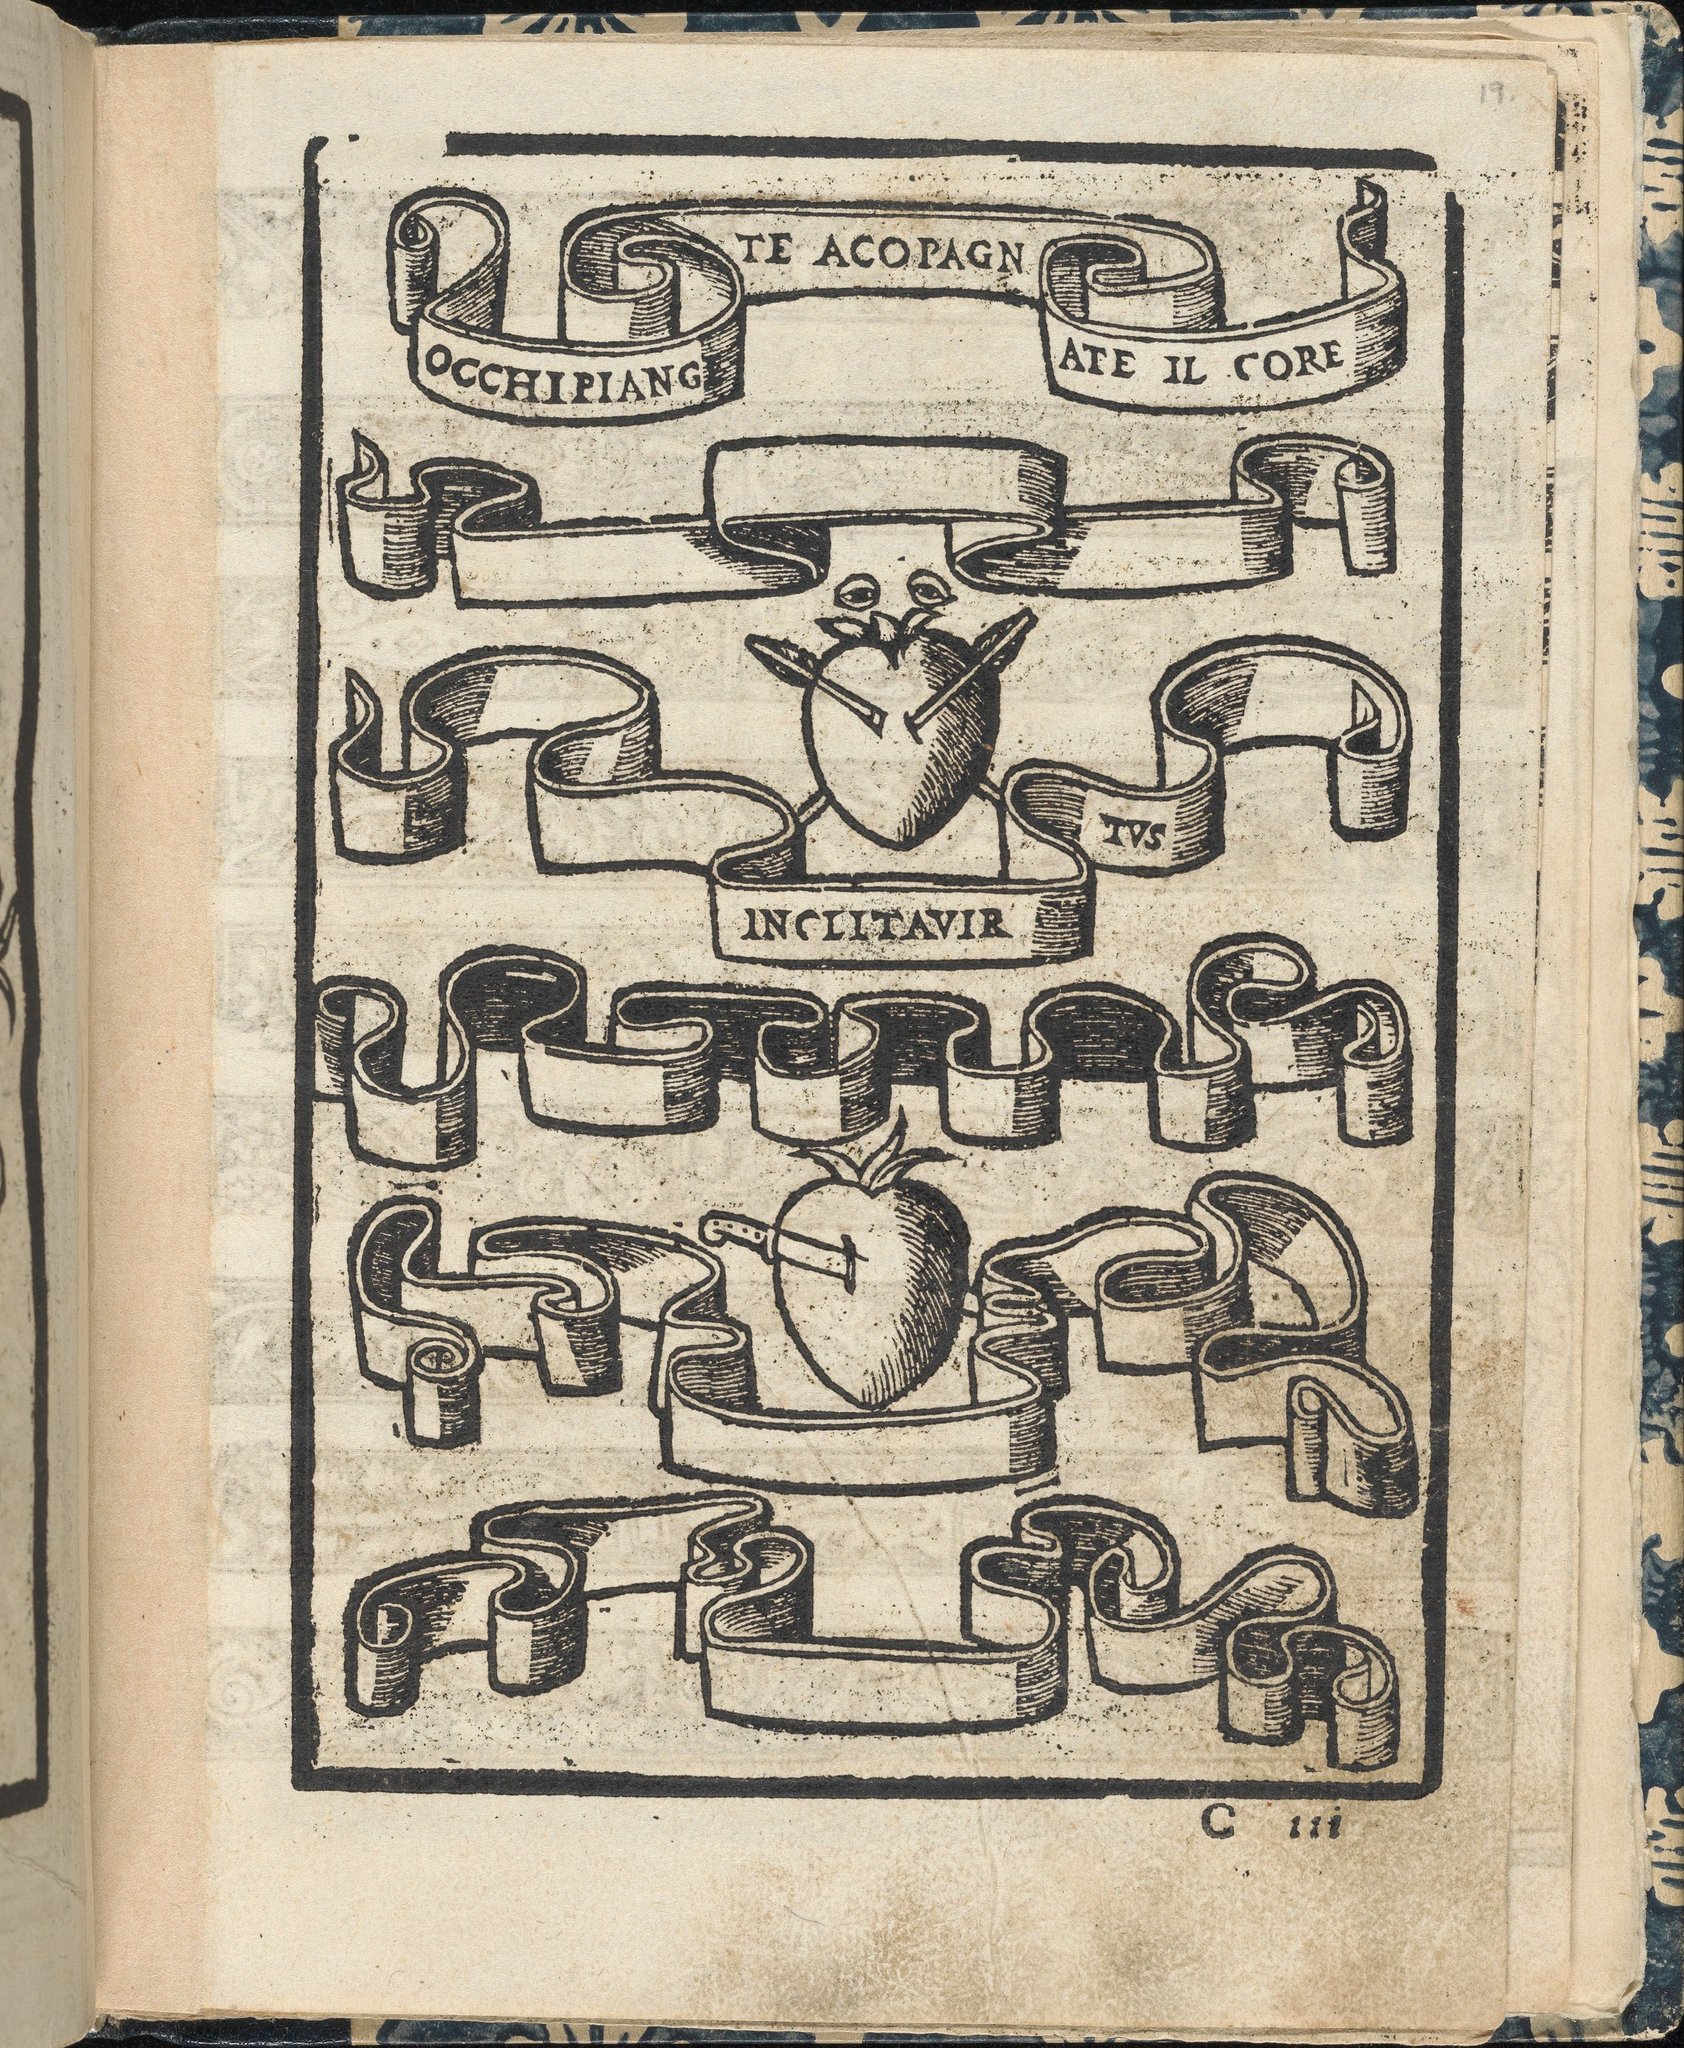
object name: book print ornament architecture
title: Essempio di recammi, page 19 (recto)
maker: giovanni antonio tagliente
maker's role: author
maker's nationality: italian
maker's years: 1465-1528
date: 1530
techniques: woodcut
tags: fruit,flags